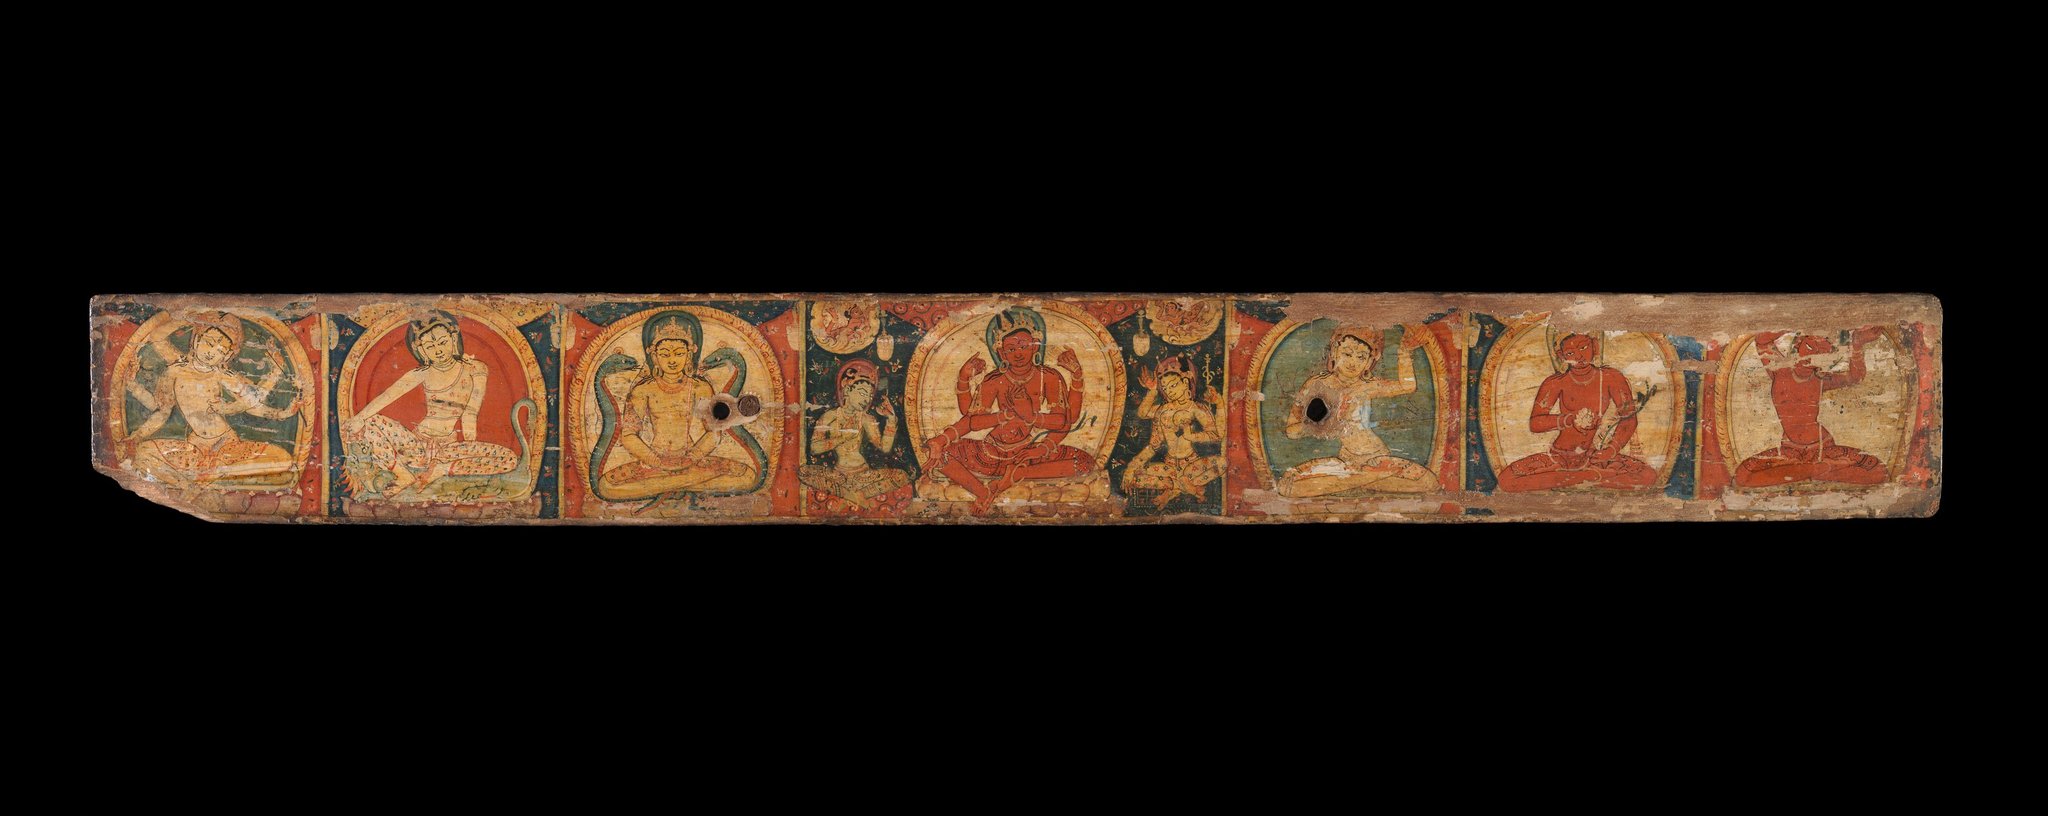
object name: manuscript cover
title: Manuscript Cover with Avalokiteshvara (The Bodhisattva of Infinite Compassion)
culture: nepali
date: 1101-1200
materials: wood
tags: avalokiteshvara,bodhisattvas,deities